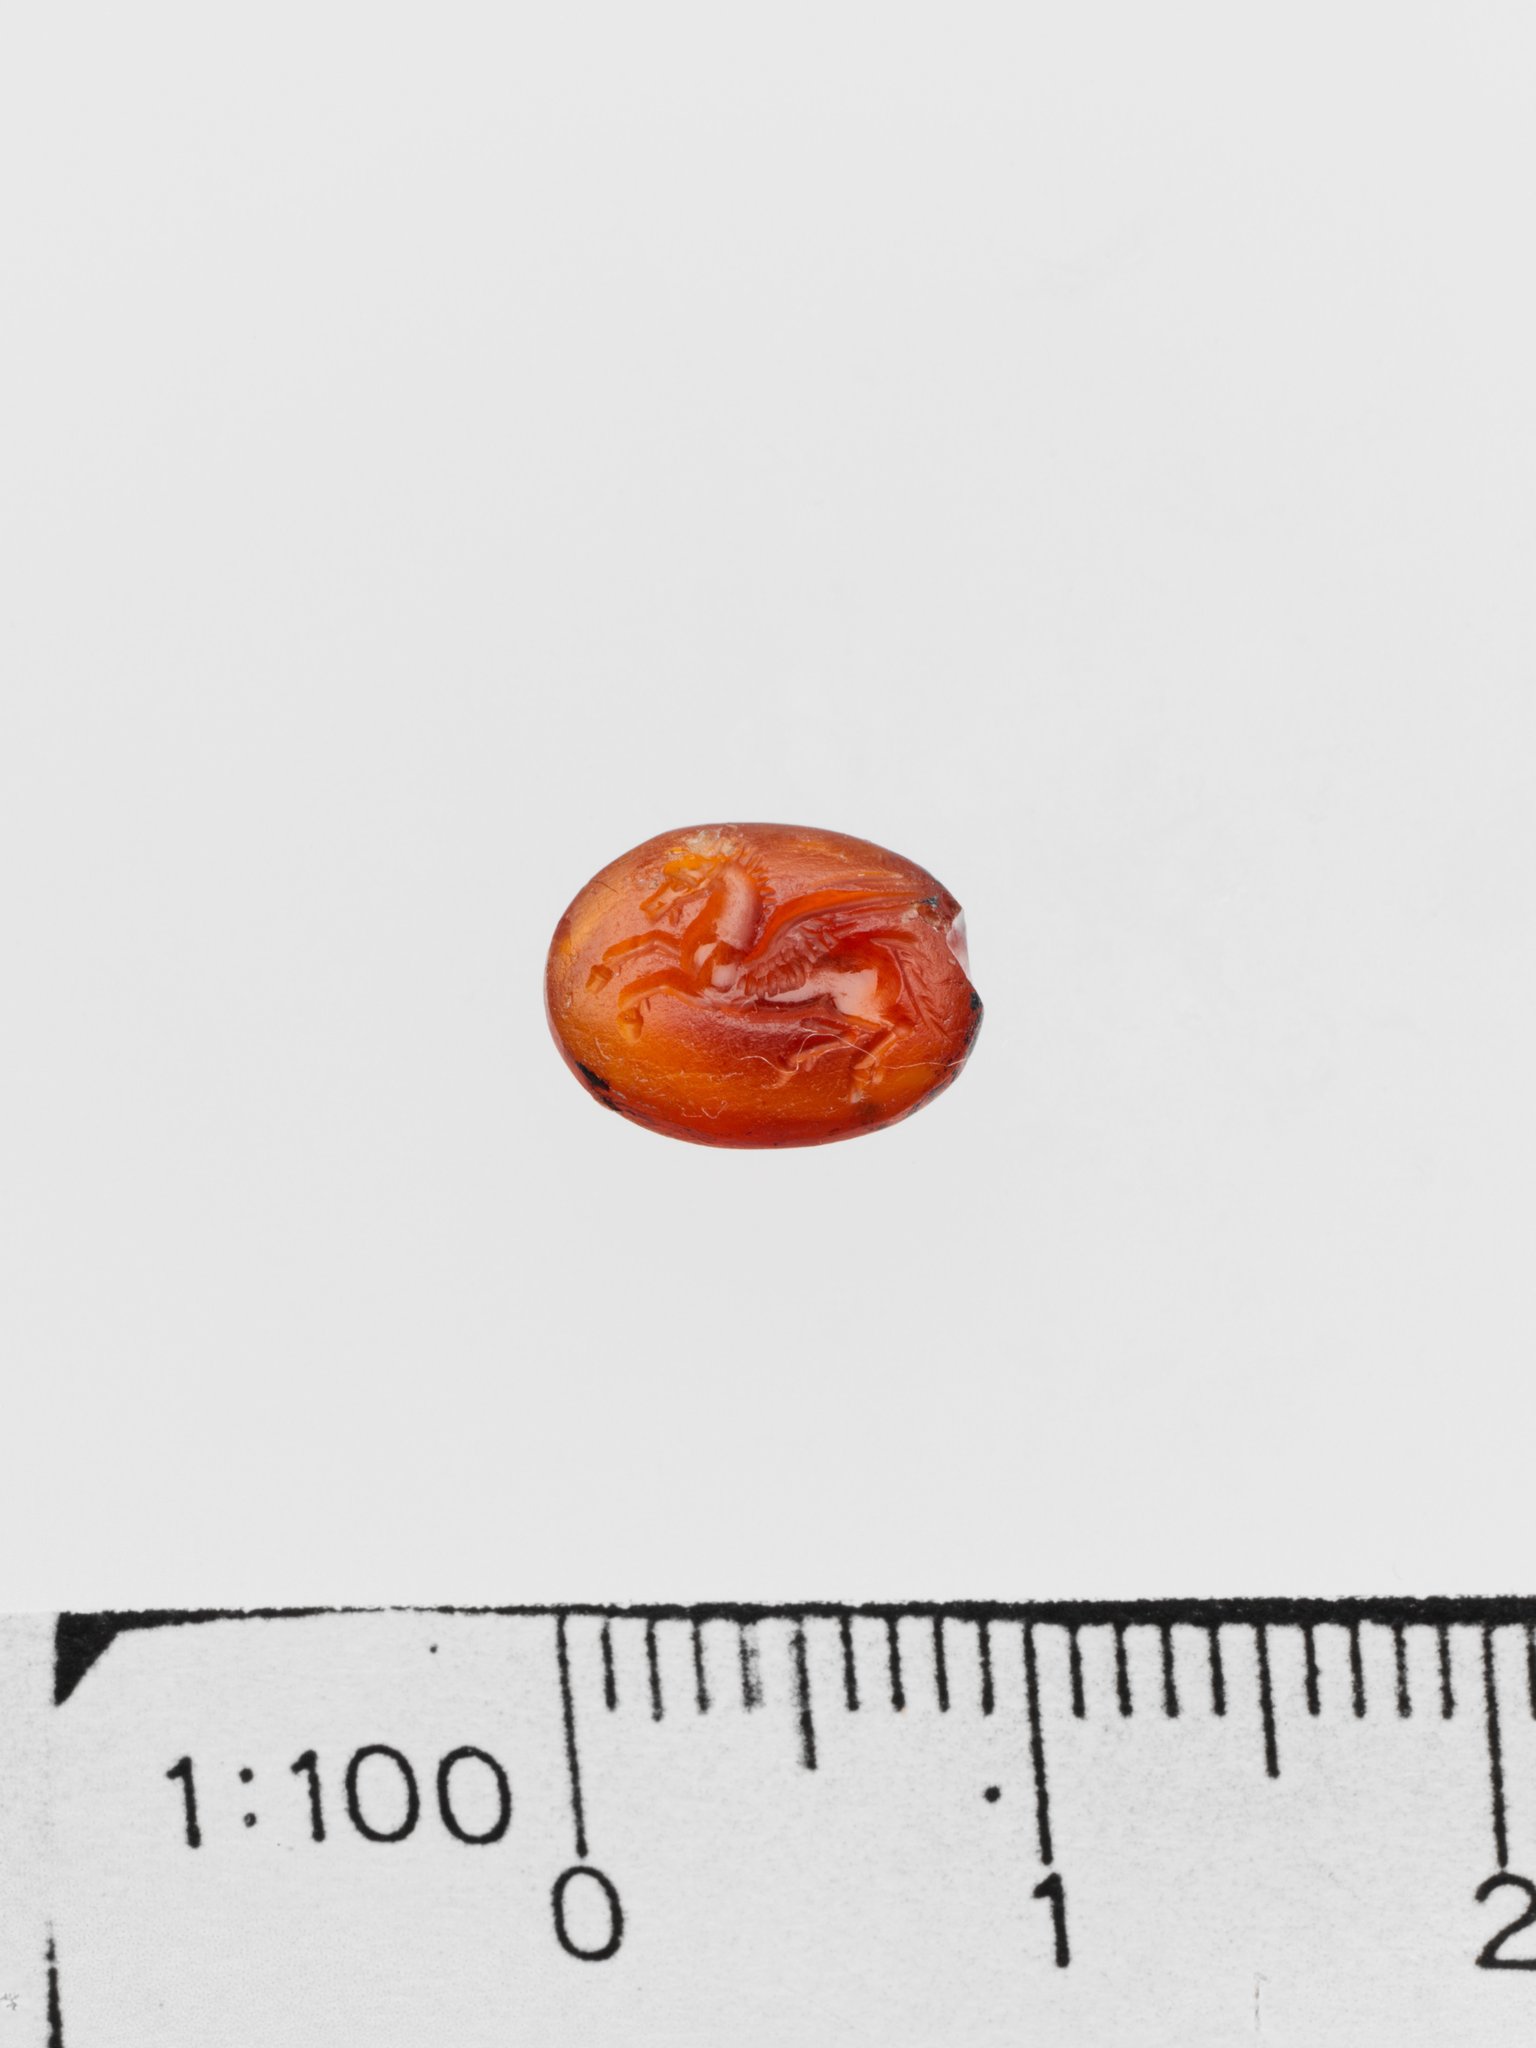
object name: intaglio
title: Carnelian ring stone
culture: roman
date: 1-100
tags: pegasus